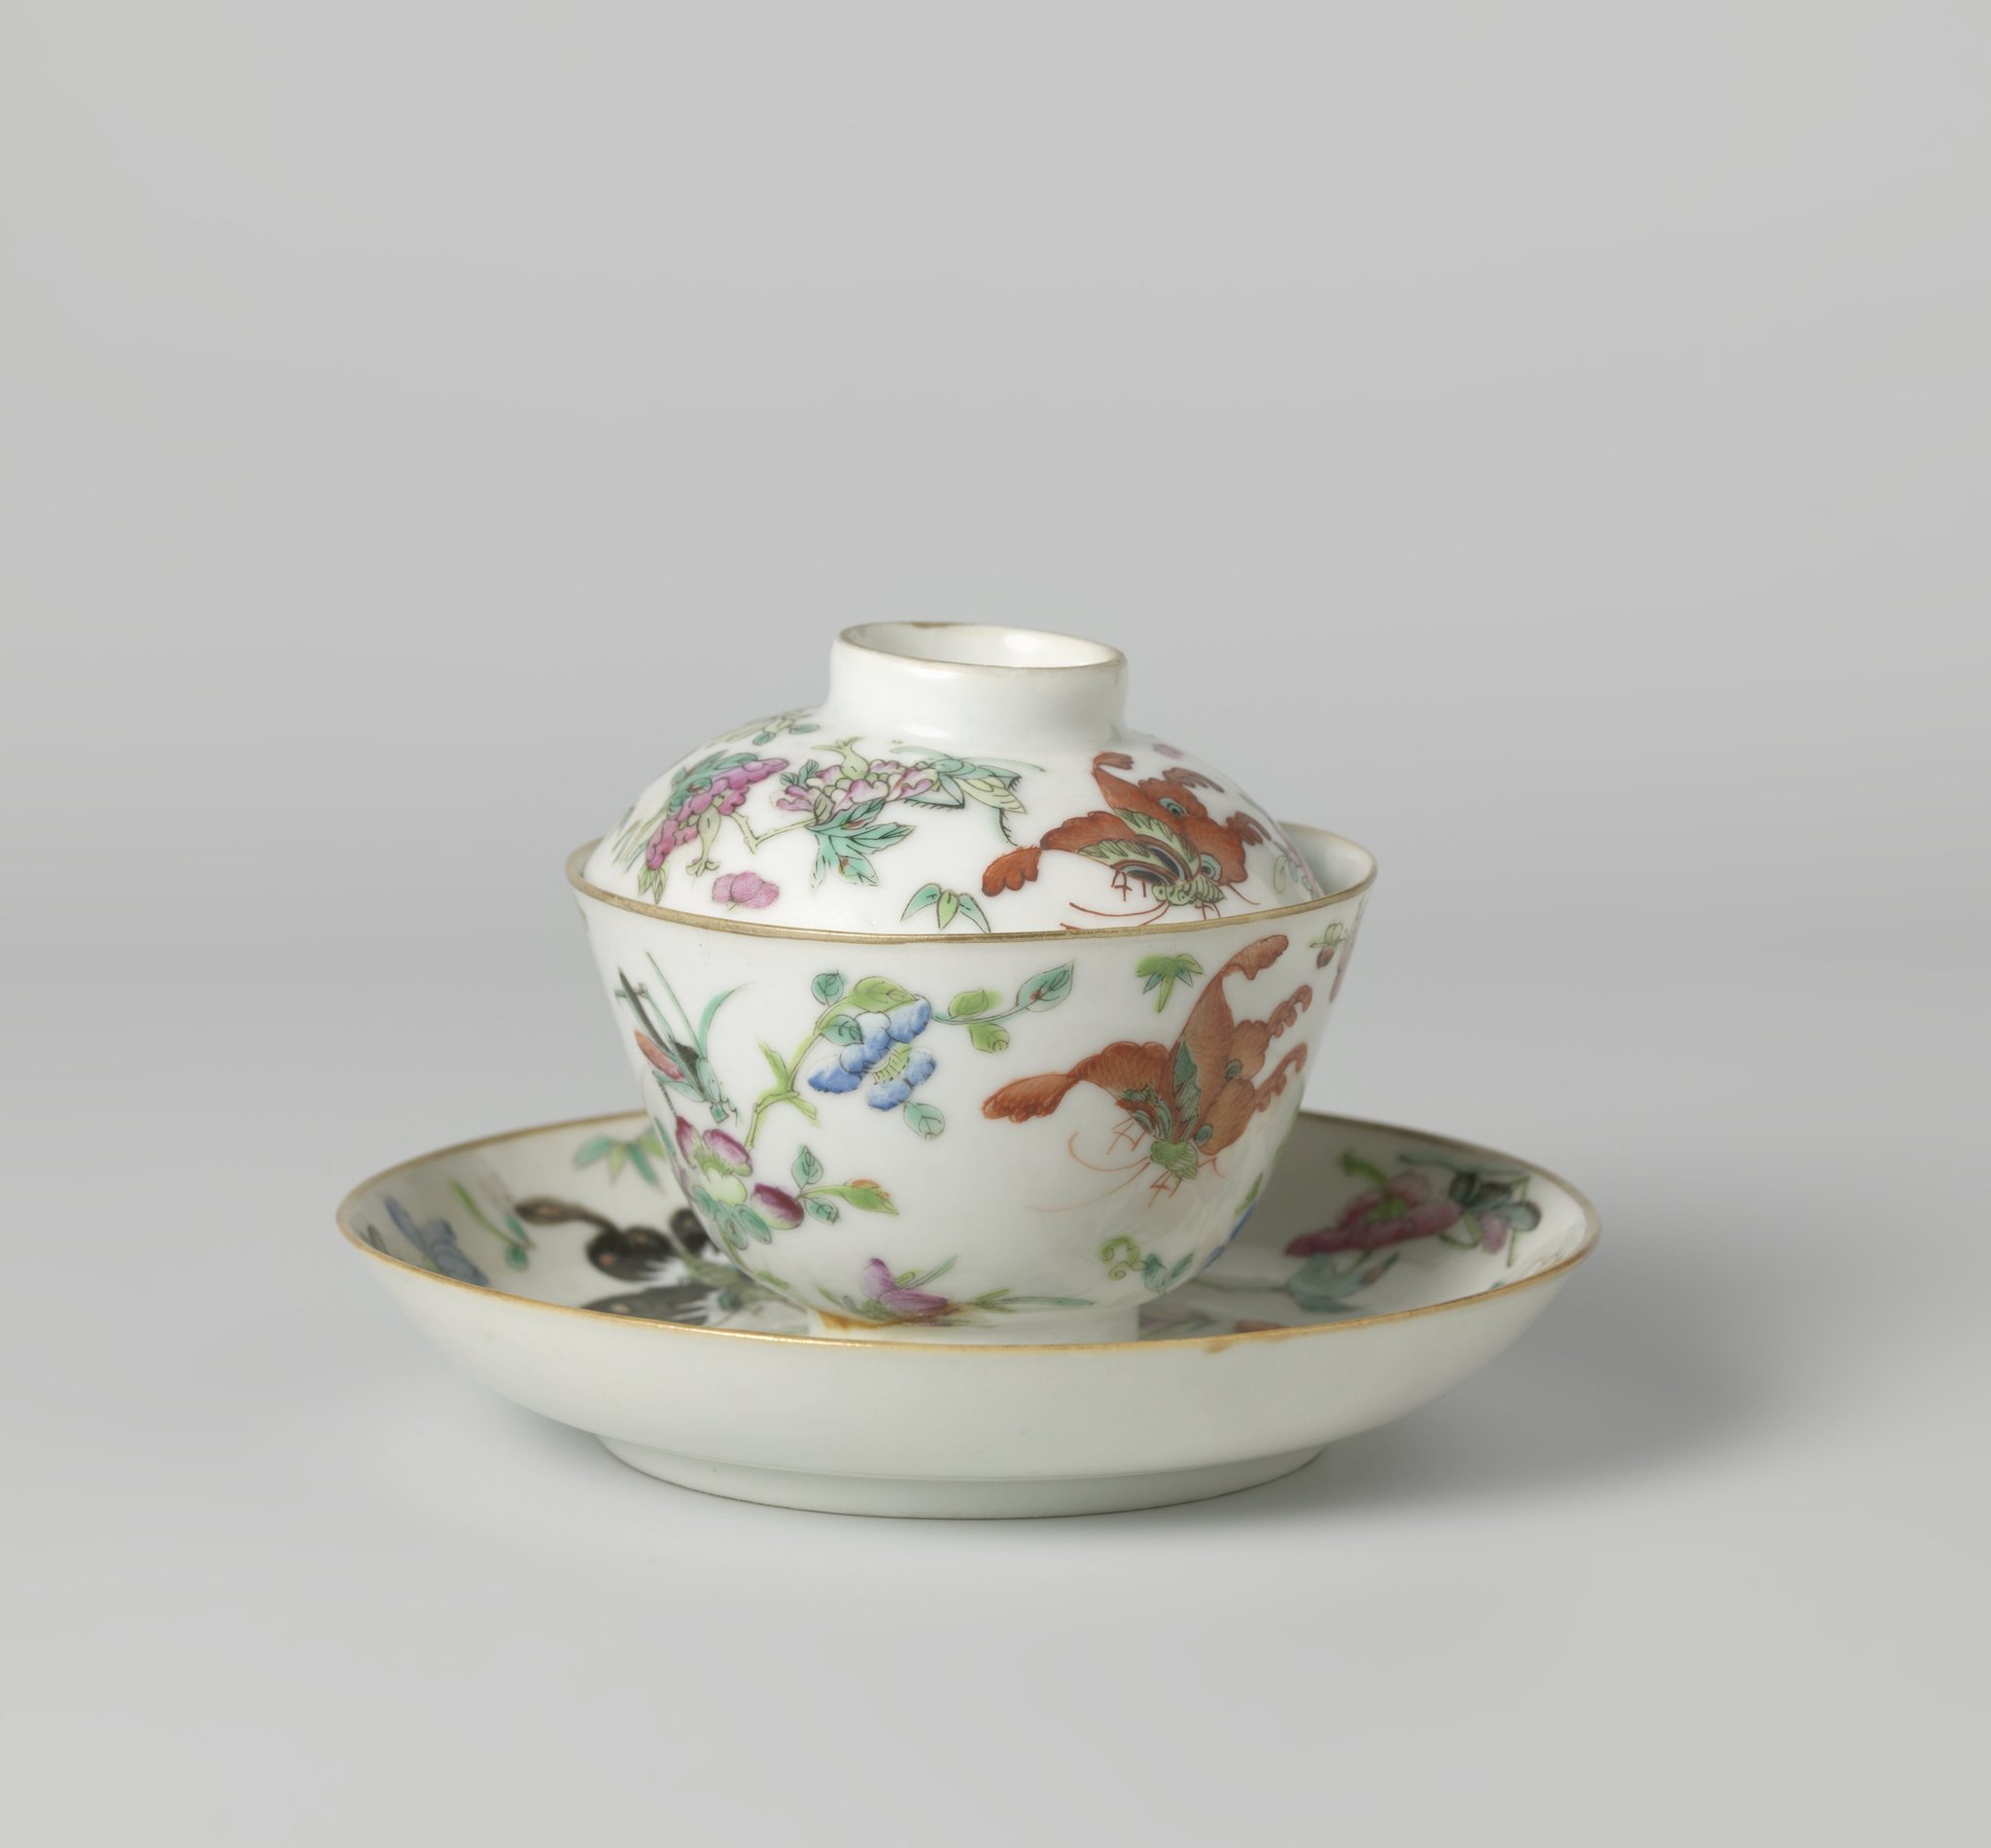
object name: lid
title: Cover with flower sprays, grasshoppers and butterflies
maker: Anonymous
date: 1800-1899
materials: glaze, paint, porcelain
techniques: firing, turning, vitrification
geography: china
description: Deksel van porselein, beschilderd op het glazuur in blauw, rood, roze, groen, geel en zwart. Met losse bloemtakken, vlinders en sprinkhanen. Gemerkt in de ringvormige knop met een ongeïdentificeerd zegelmerk. Famille rose.